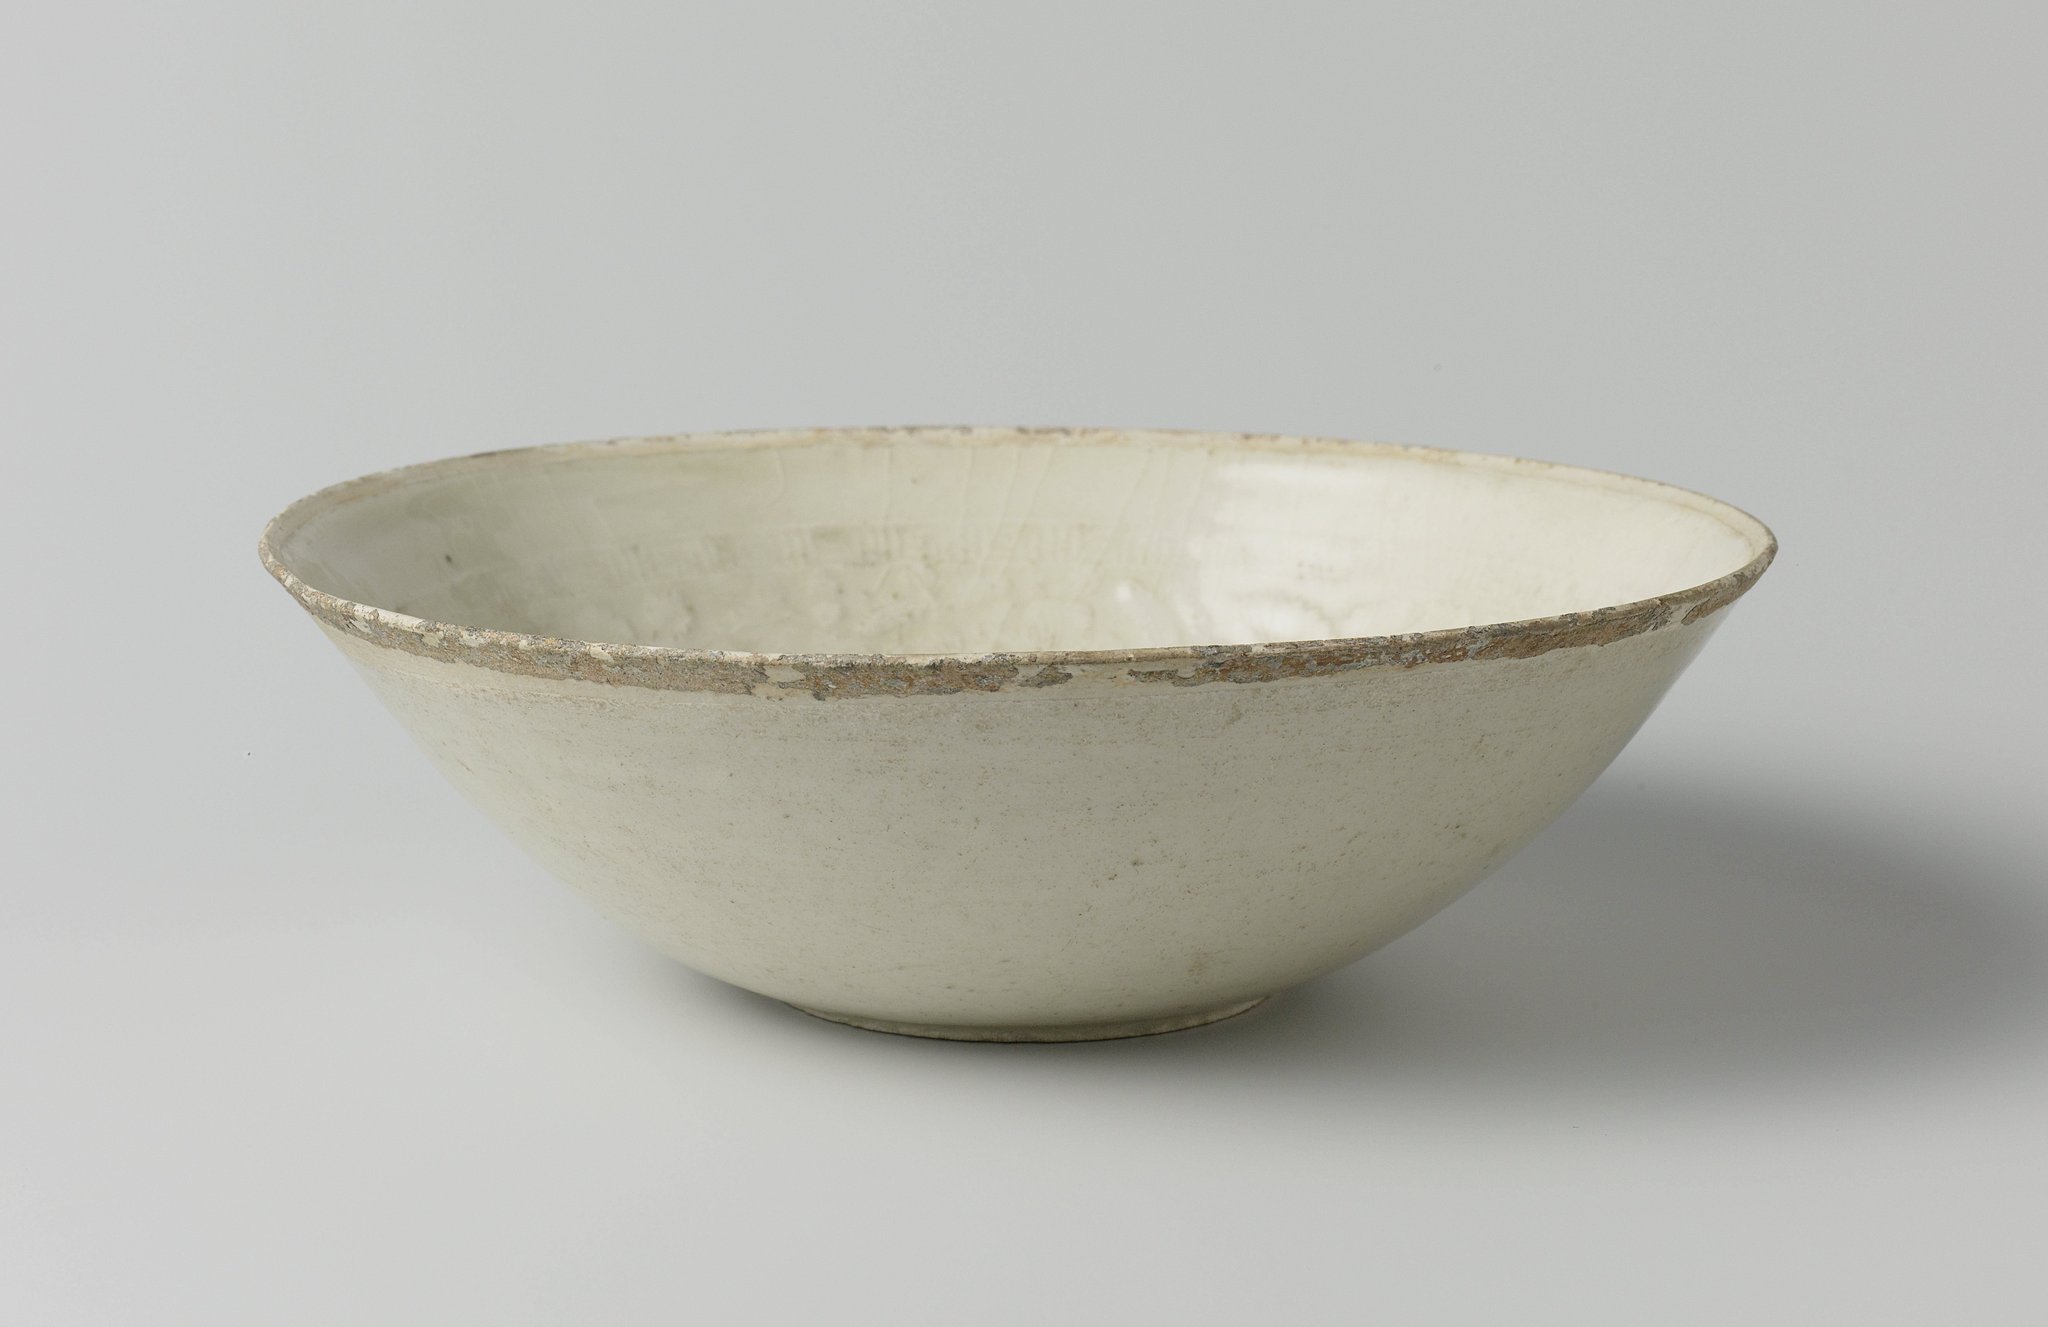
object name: bowl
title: Bowl with lotus flowers, feng huangs and floral scrolls in relief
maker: Anonymous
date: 960-1279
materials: glaze, stoneware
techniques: firing, relief, turning, vitrification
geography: china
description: Wijde kom van steengoed, bedekt met een gecraqueleerd, transparant glazuur met een lichtblauwe tint. Op de bodem een gestileerde lotusbloem in reliëf. De binnenwand met een brede band met bloemranken met daarin twee feng huangs; daarboven een decoratieve band met een geometrisch motief. Een barst in de rand. Qingbai.